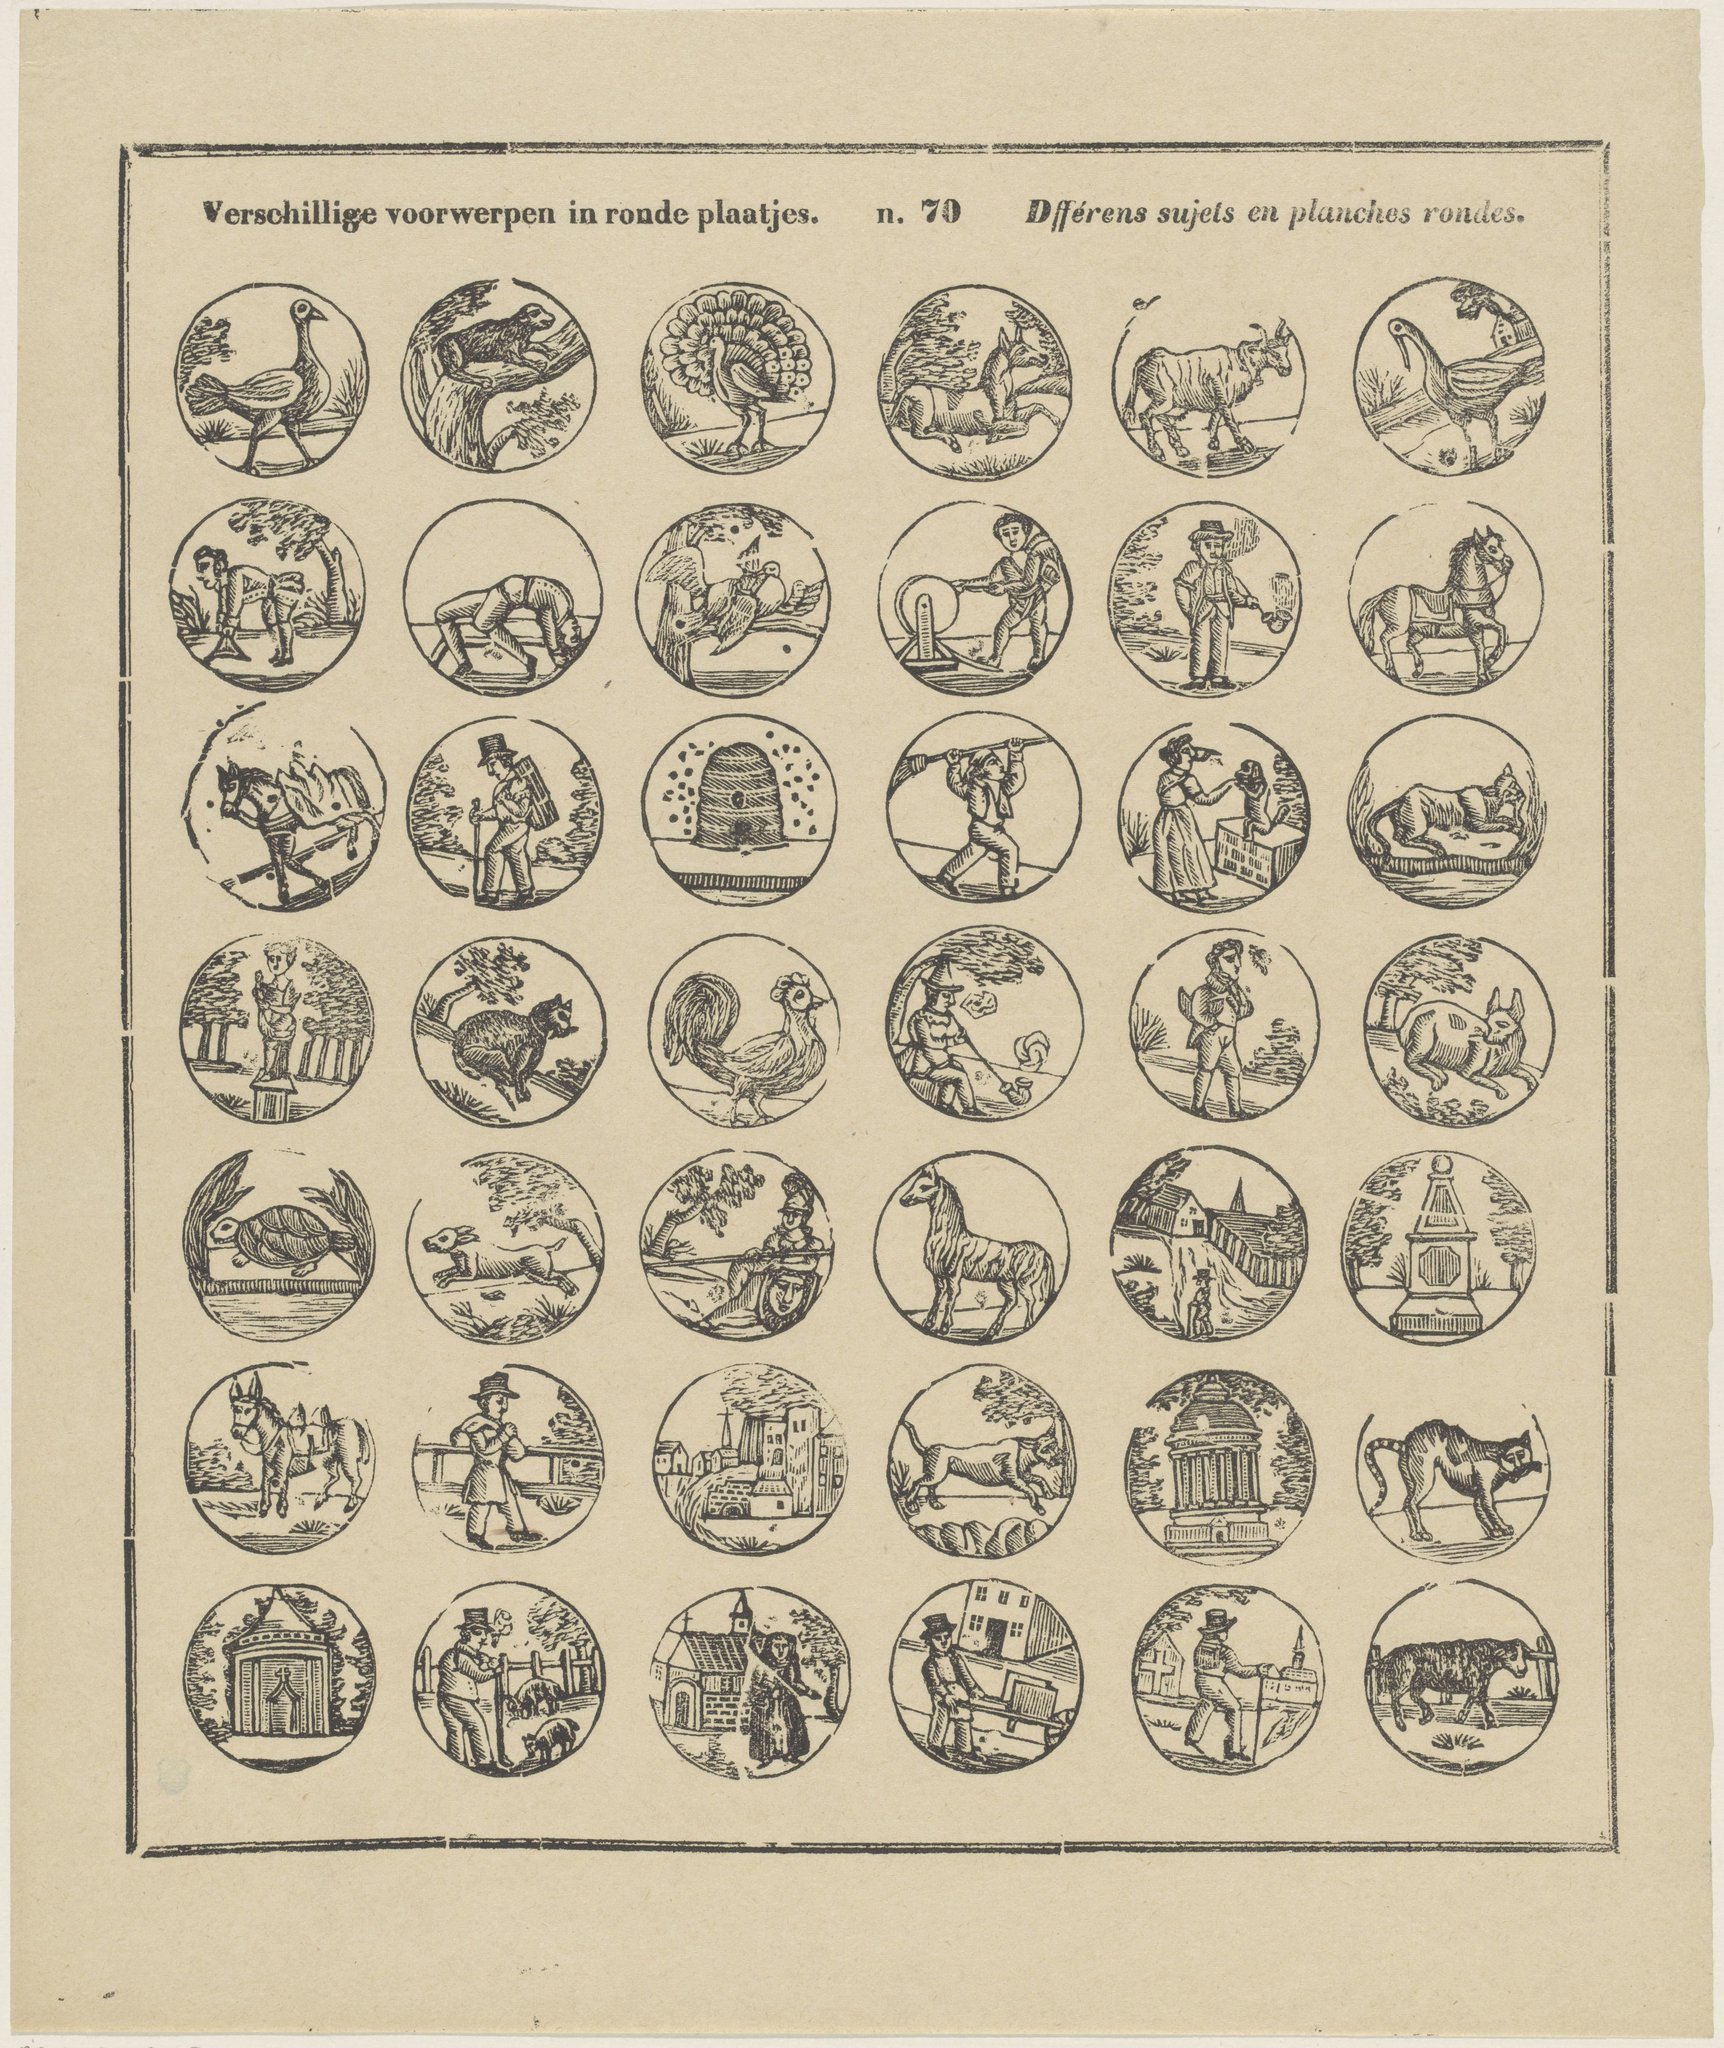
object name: popular print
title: Verschillige voorwerpen in ronde plaatjes / Différens sujets en planches rondes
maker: Anonymous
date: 1856-1900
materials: paper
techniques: letterpress printing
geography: turnhout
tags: animals, characters (human types)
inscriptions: collector's mark: Lugt 2760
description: Blad met 42 ronde voorstellingen van dieren, figuren en bouwwerken. Genummerd midden boven: n. 70.